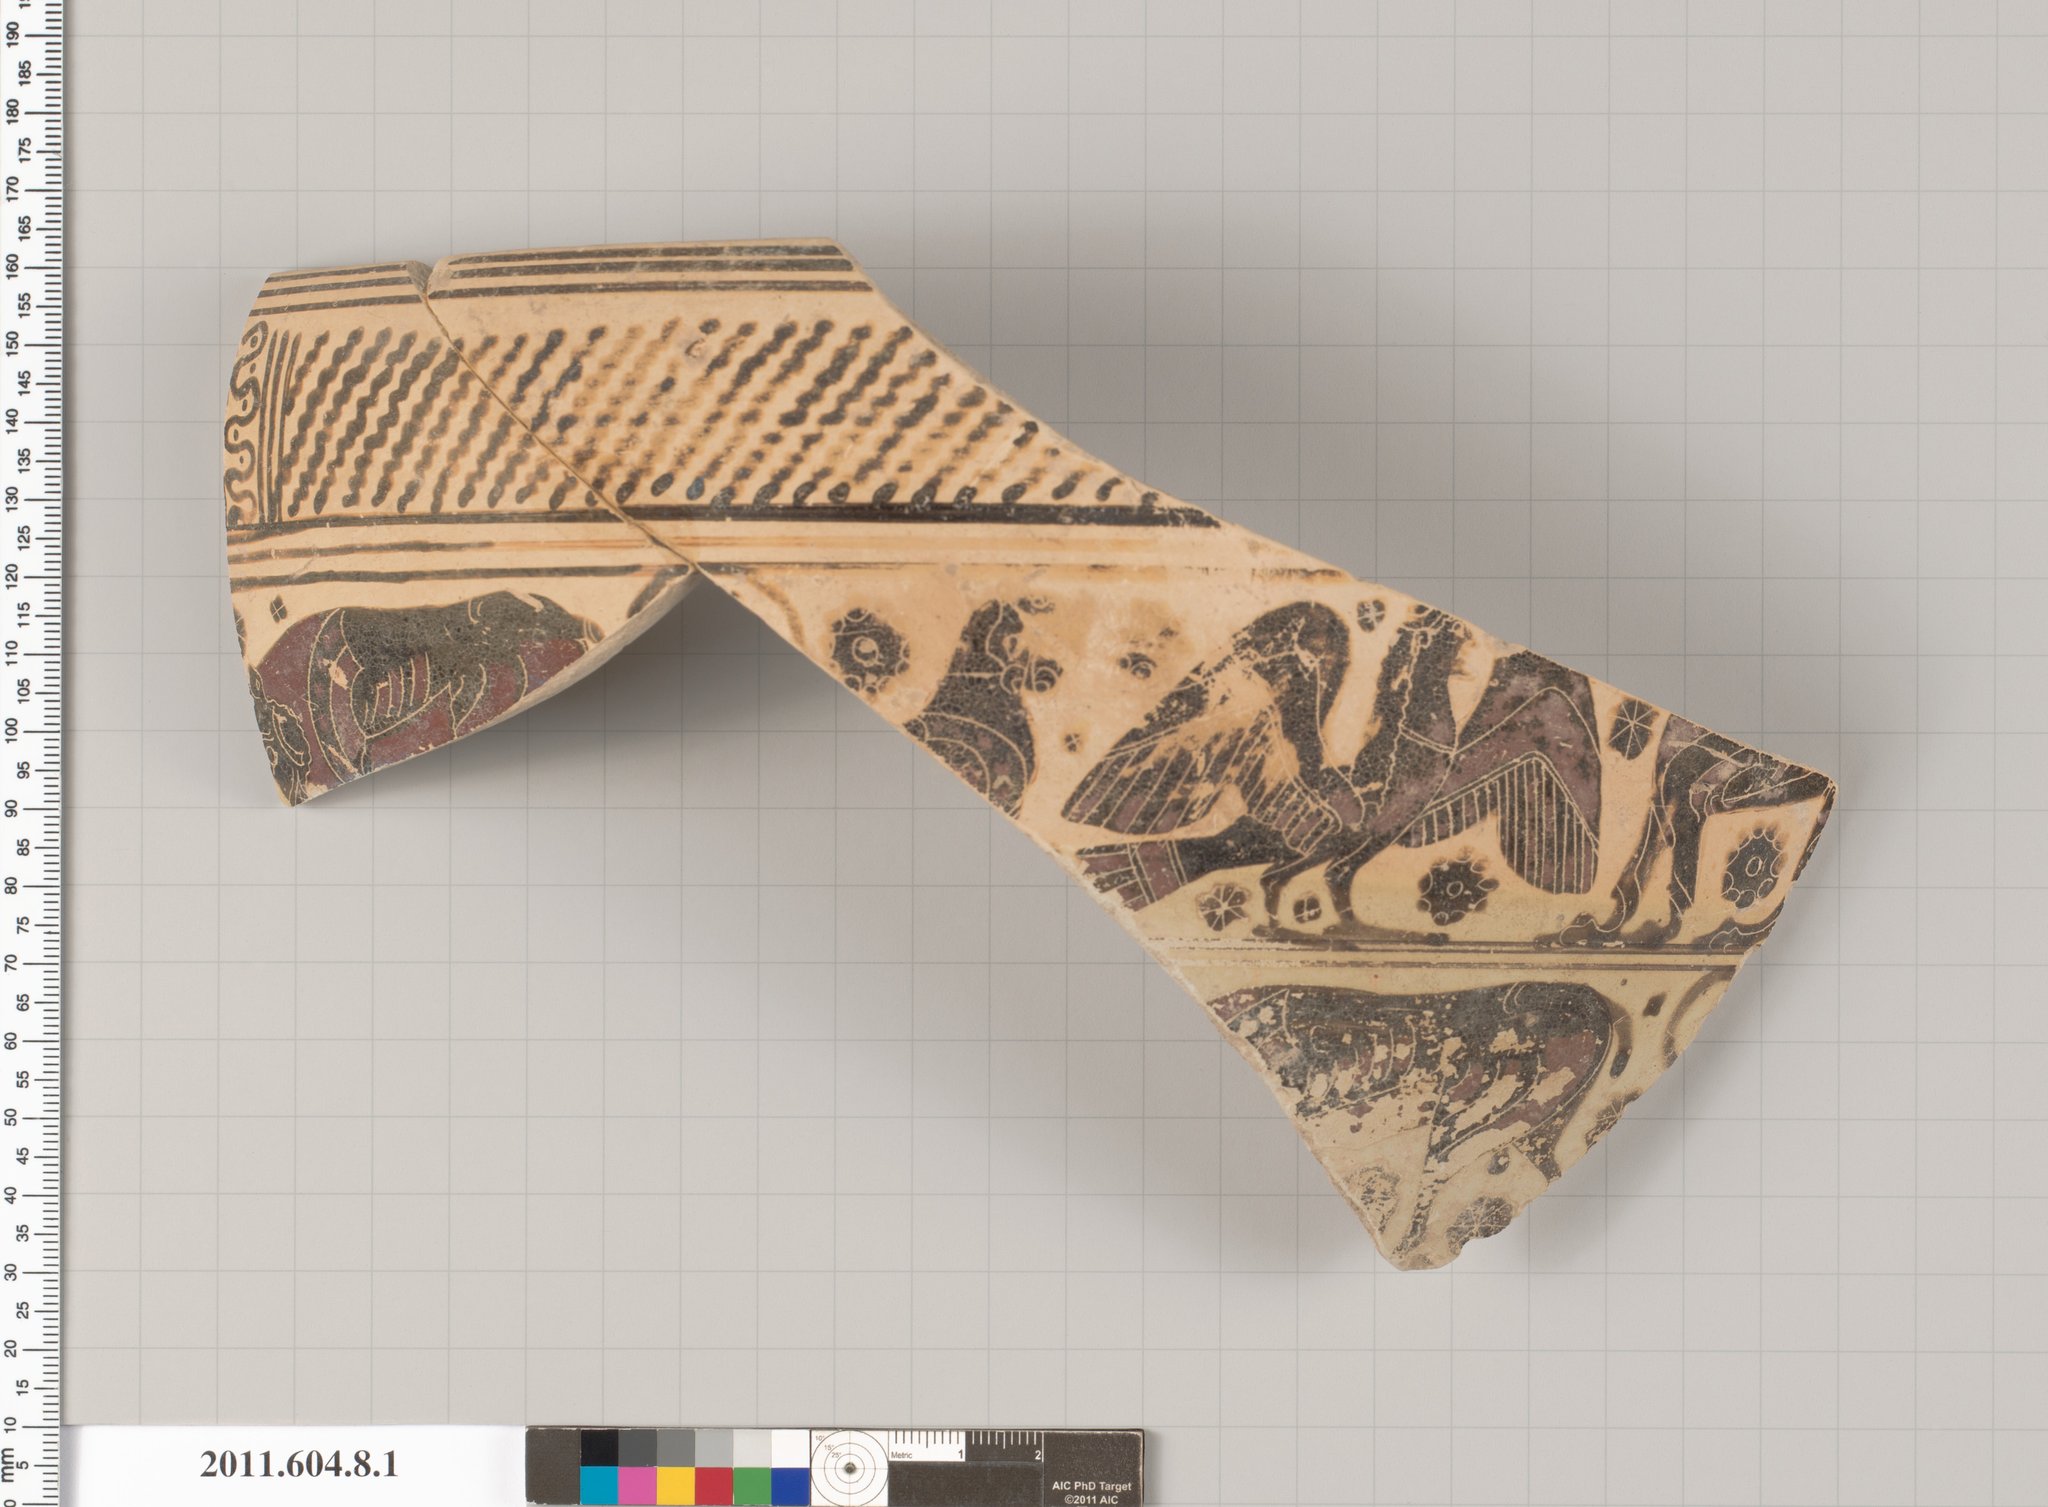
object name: undetermined open shape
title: Terracotta fragment of an open shape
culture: greek, corinthian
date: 550-501 BCE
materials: terracotta